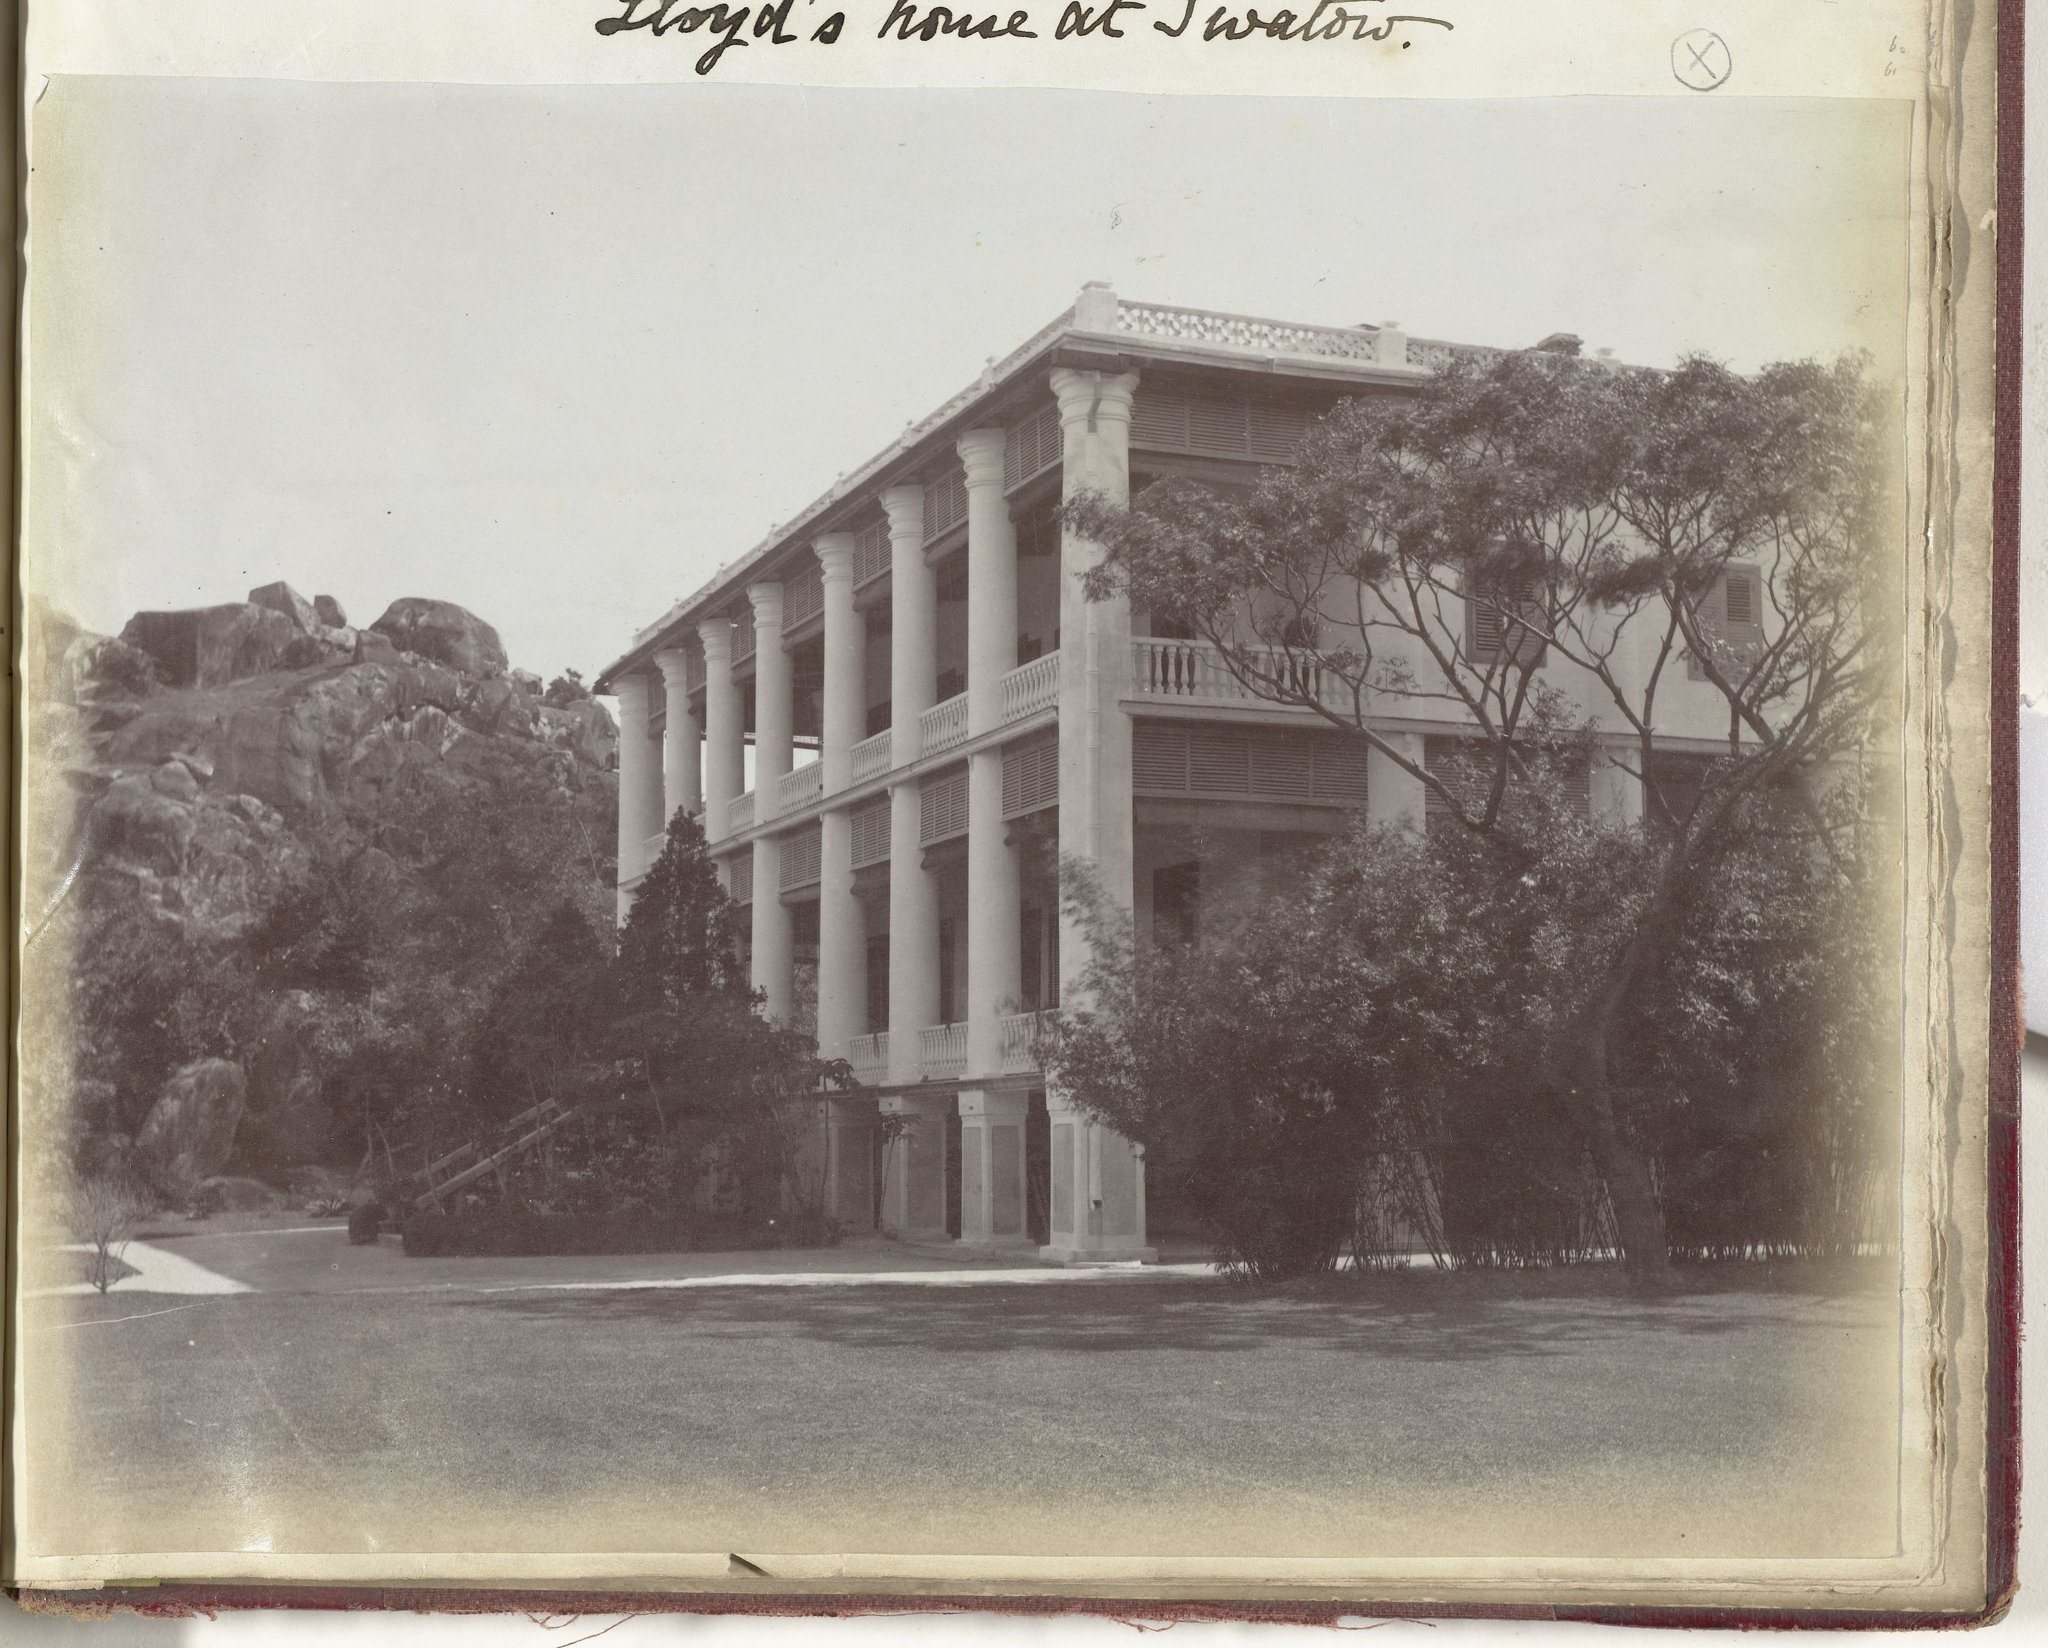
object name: album leaf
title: Huis van het hoofd van de douane J. Lloyd E. Palm, Shantou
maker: Anonymous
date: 1879-1890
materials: paper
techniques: albumen print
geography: shantou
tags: country-house, shantou